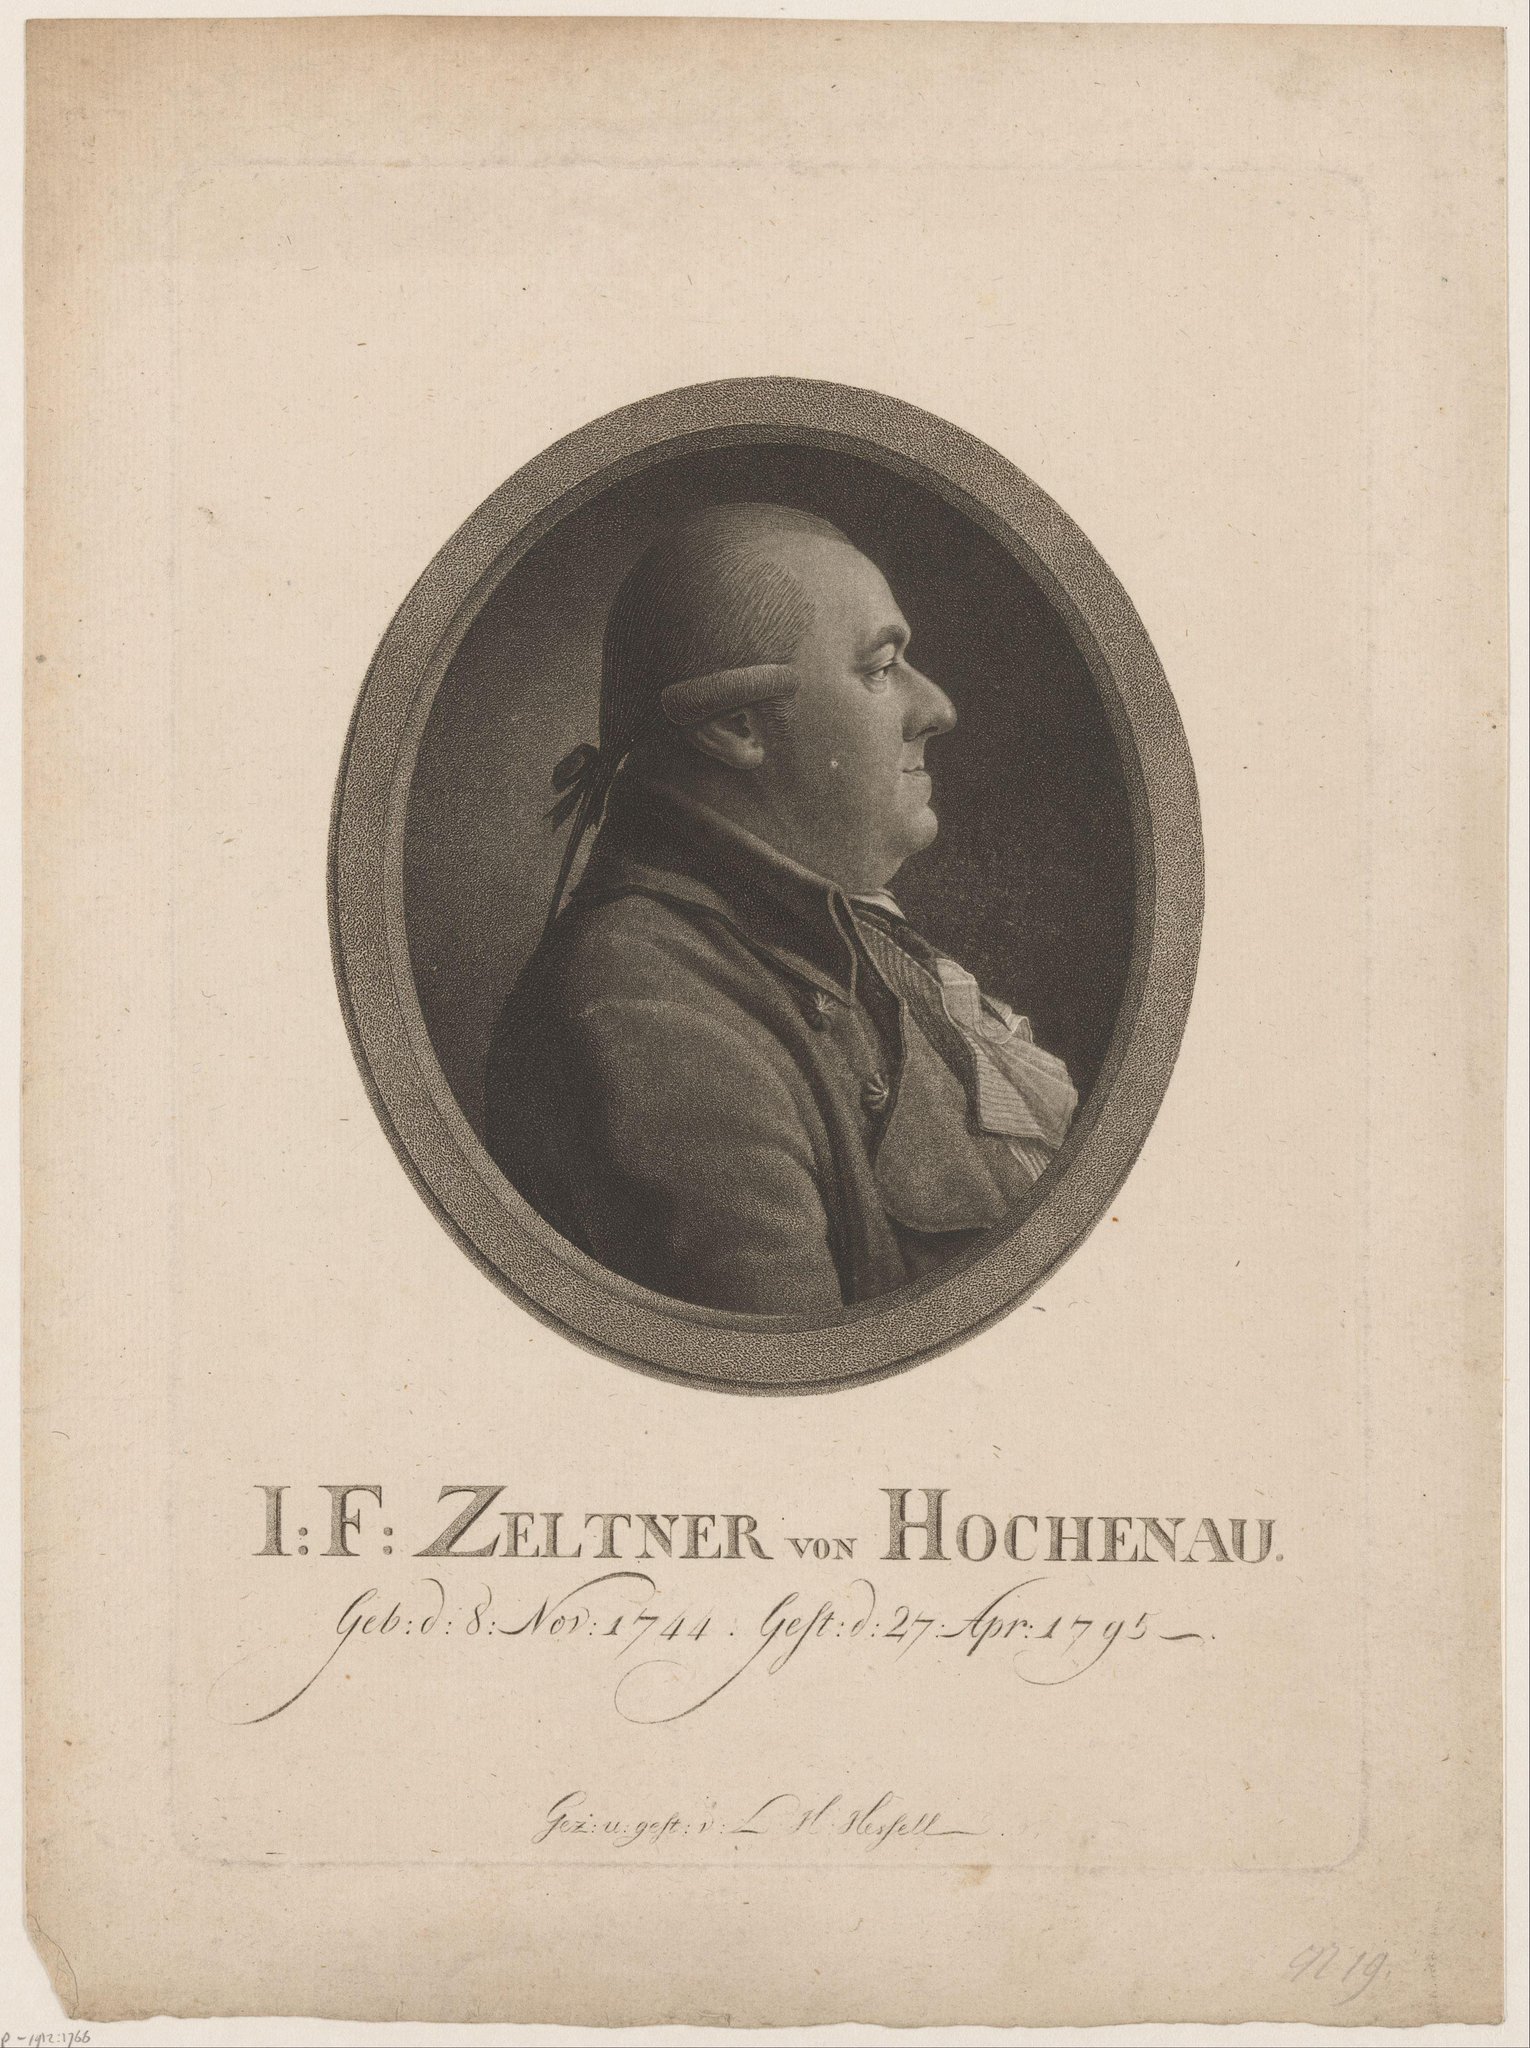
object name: print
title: Portret van I.F. Zeltner von Hochenau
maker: leonhard heinrich hessell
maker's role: musical instrument maker, painter, print maker, publisher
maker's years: 1757-1830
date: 1795-1830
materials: paper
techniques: aquatint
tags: historical persons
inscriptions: collector's mark: Lugt 2228